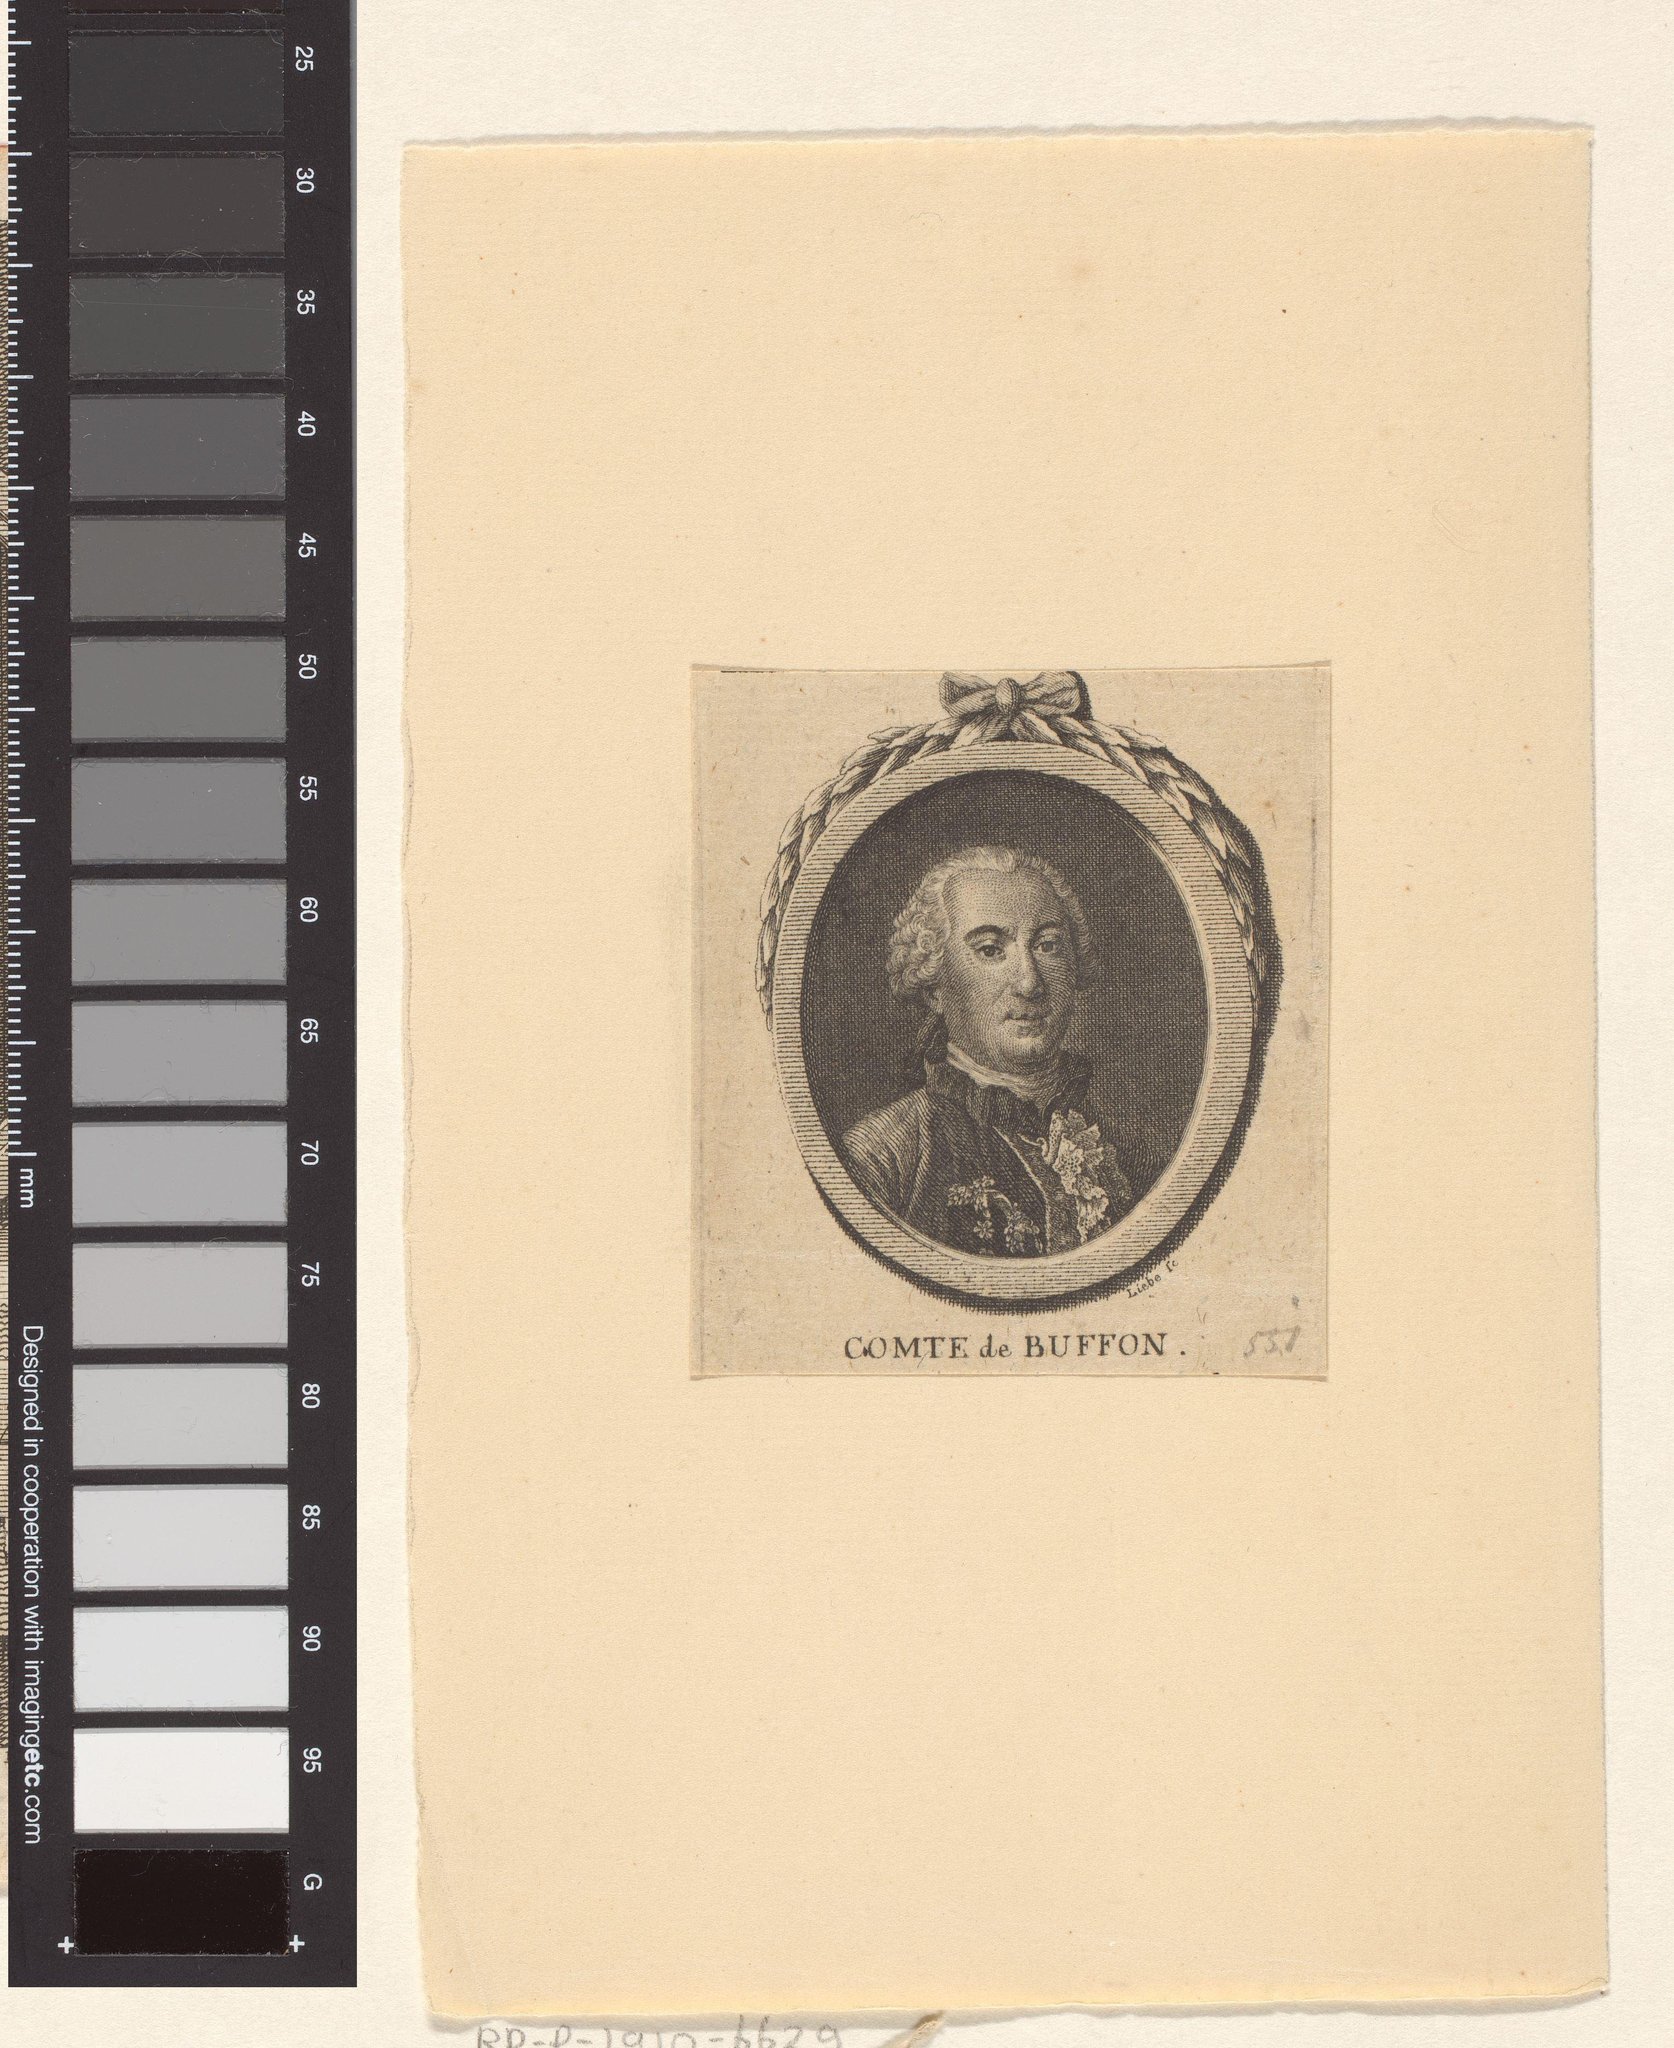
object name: print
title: Portret van Georges-Louis Leclerc de Buffon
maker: gottlob august liebe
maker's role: draughtsman, print maker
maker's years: 1746-1819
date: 1773-1819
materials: paper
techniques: engraving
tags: paris, georges-louis leclerc de buffon (graaf), historical persons, biology (+ portrait of scholar, scientist)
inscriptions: collector's mark: Lugt 2228